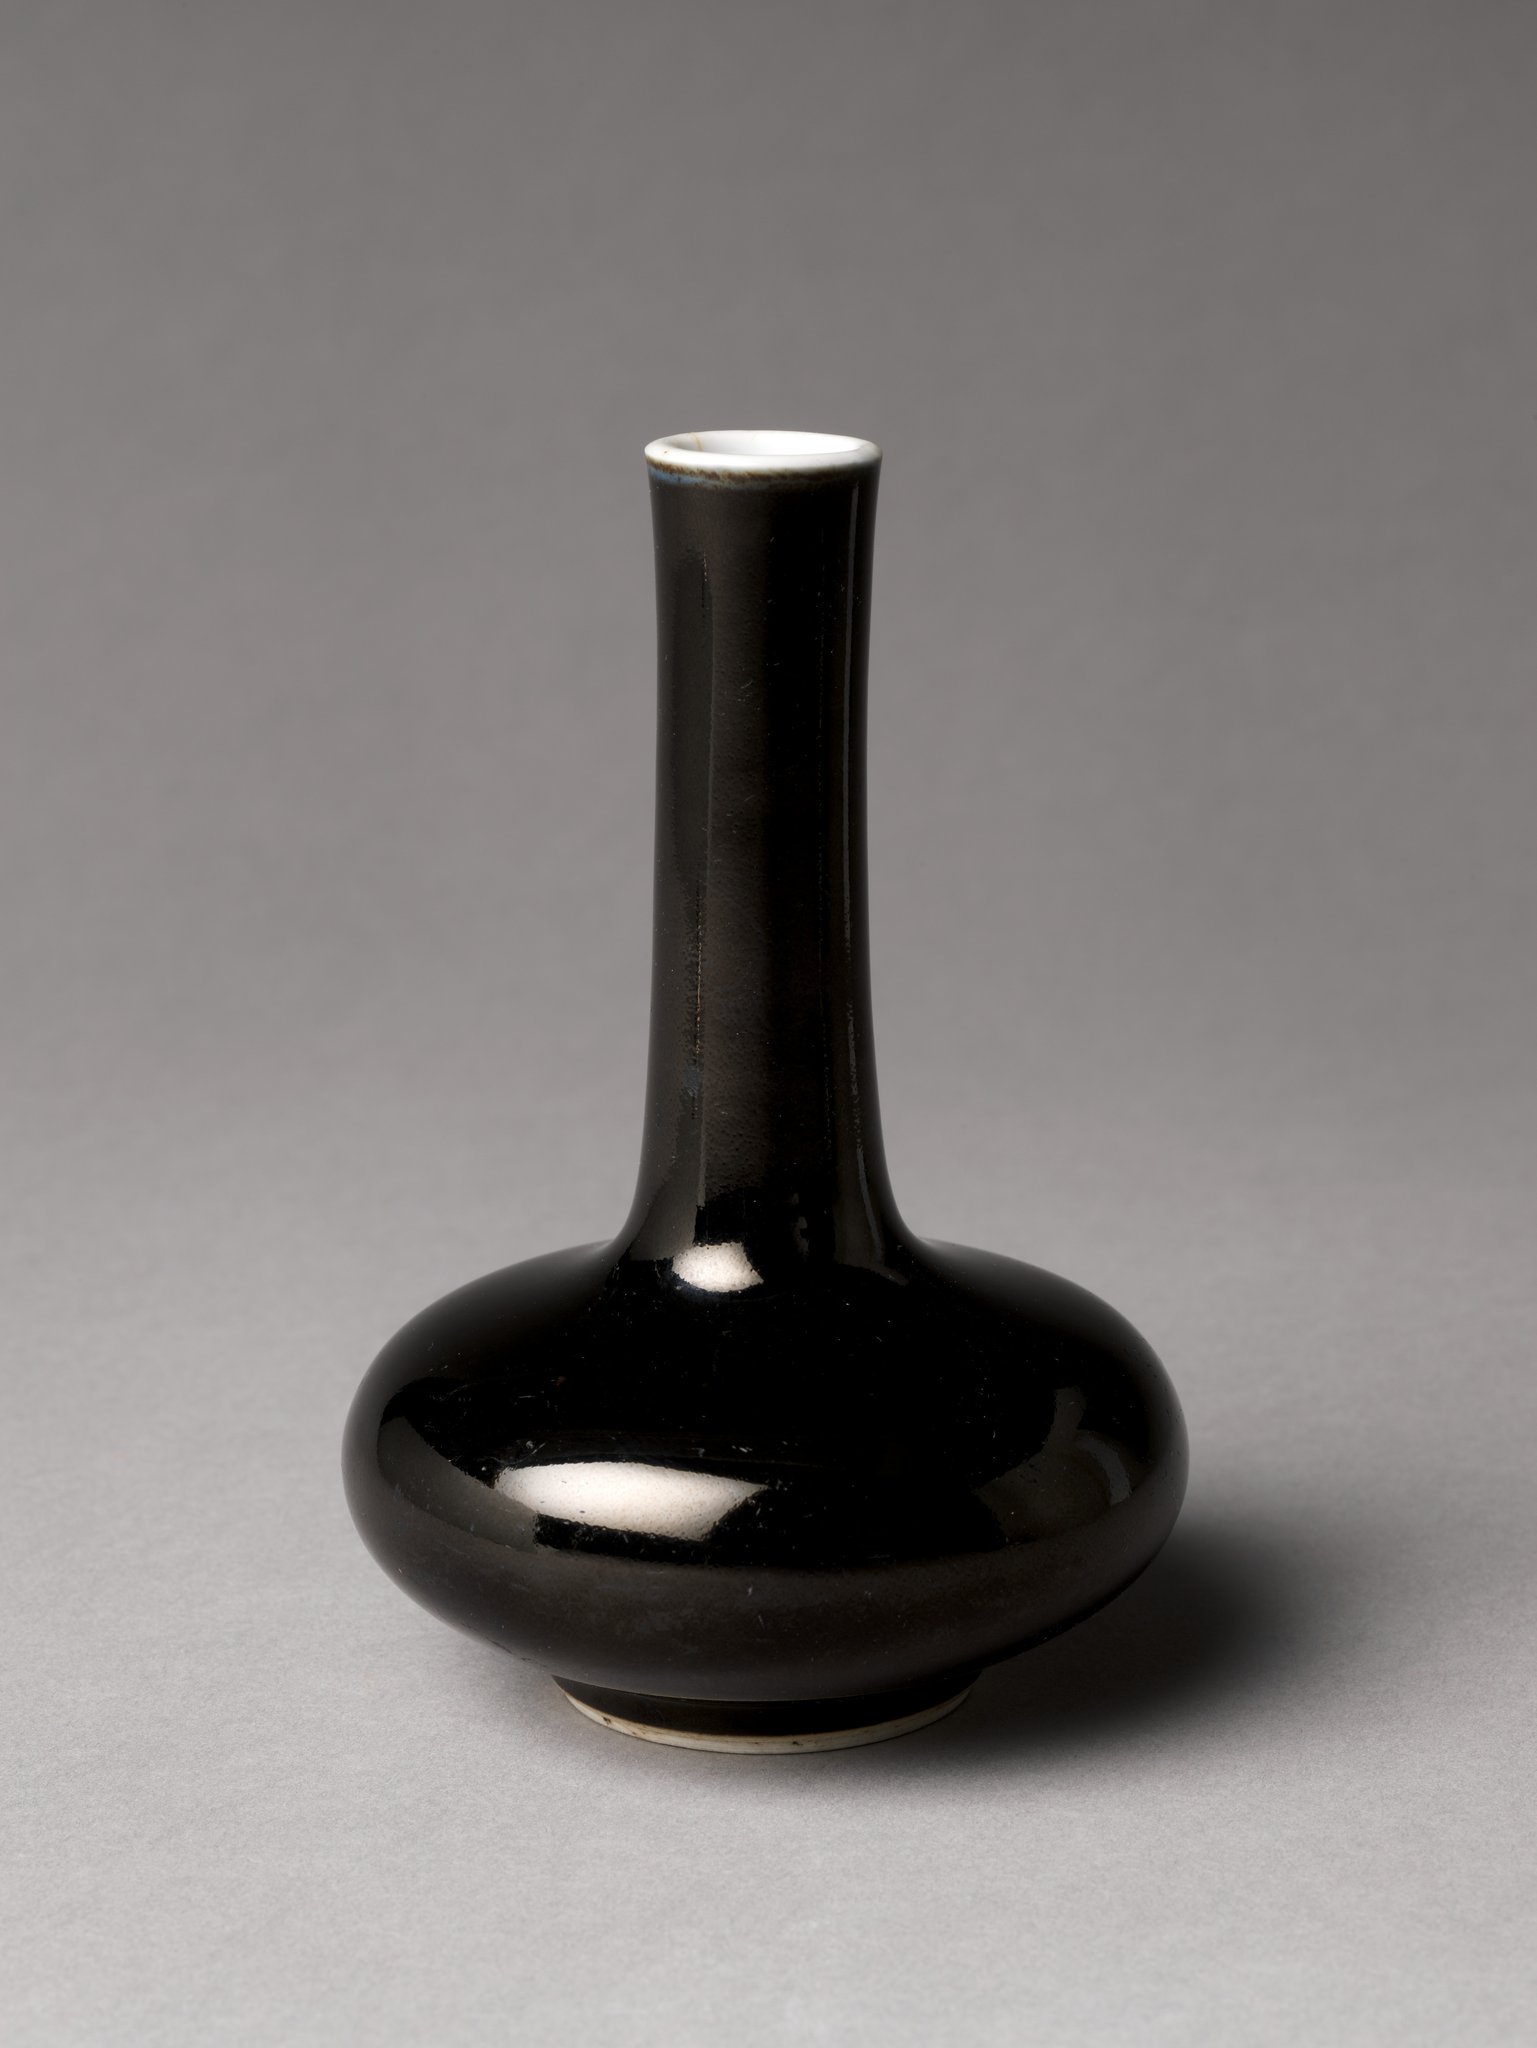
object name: vase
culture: chinese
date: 1667-1733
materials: glaze, porcelain